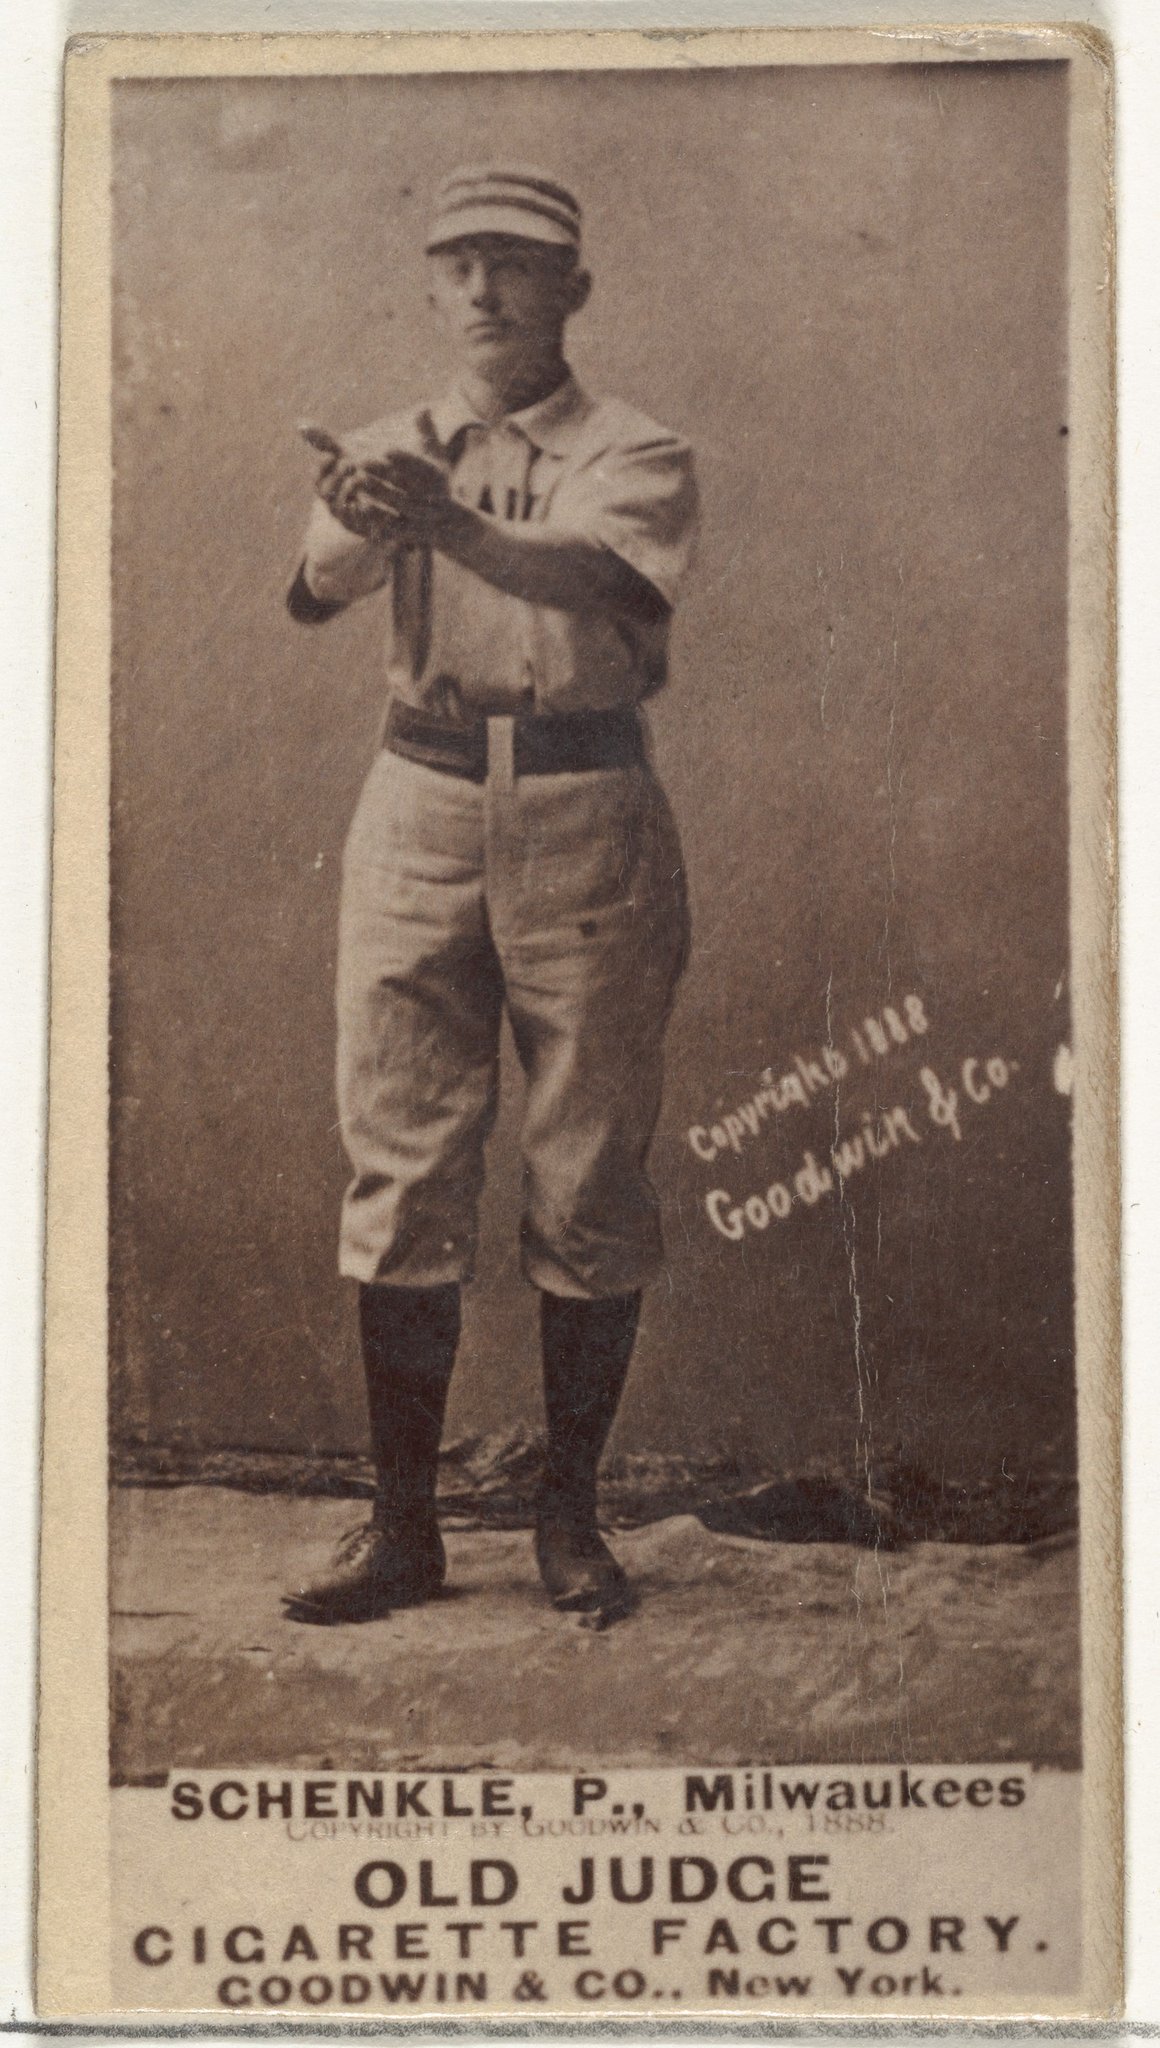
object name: baseball card, photograph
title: William Shenkel, Pitcher, Milwaukee, from the Old Judge series (N172) for Old Judge Cigarettes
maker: goodwin & company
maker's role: publisher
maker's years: 1850-1950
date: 1888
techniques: albumen silver print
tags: men,portraits,baseball,athletes